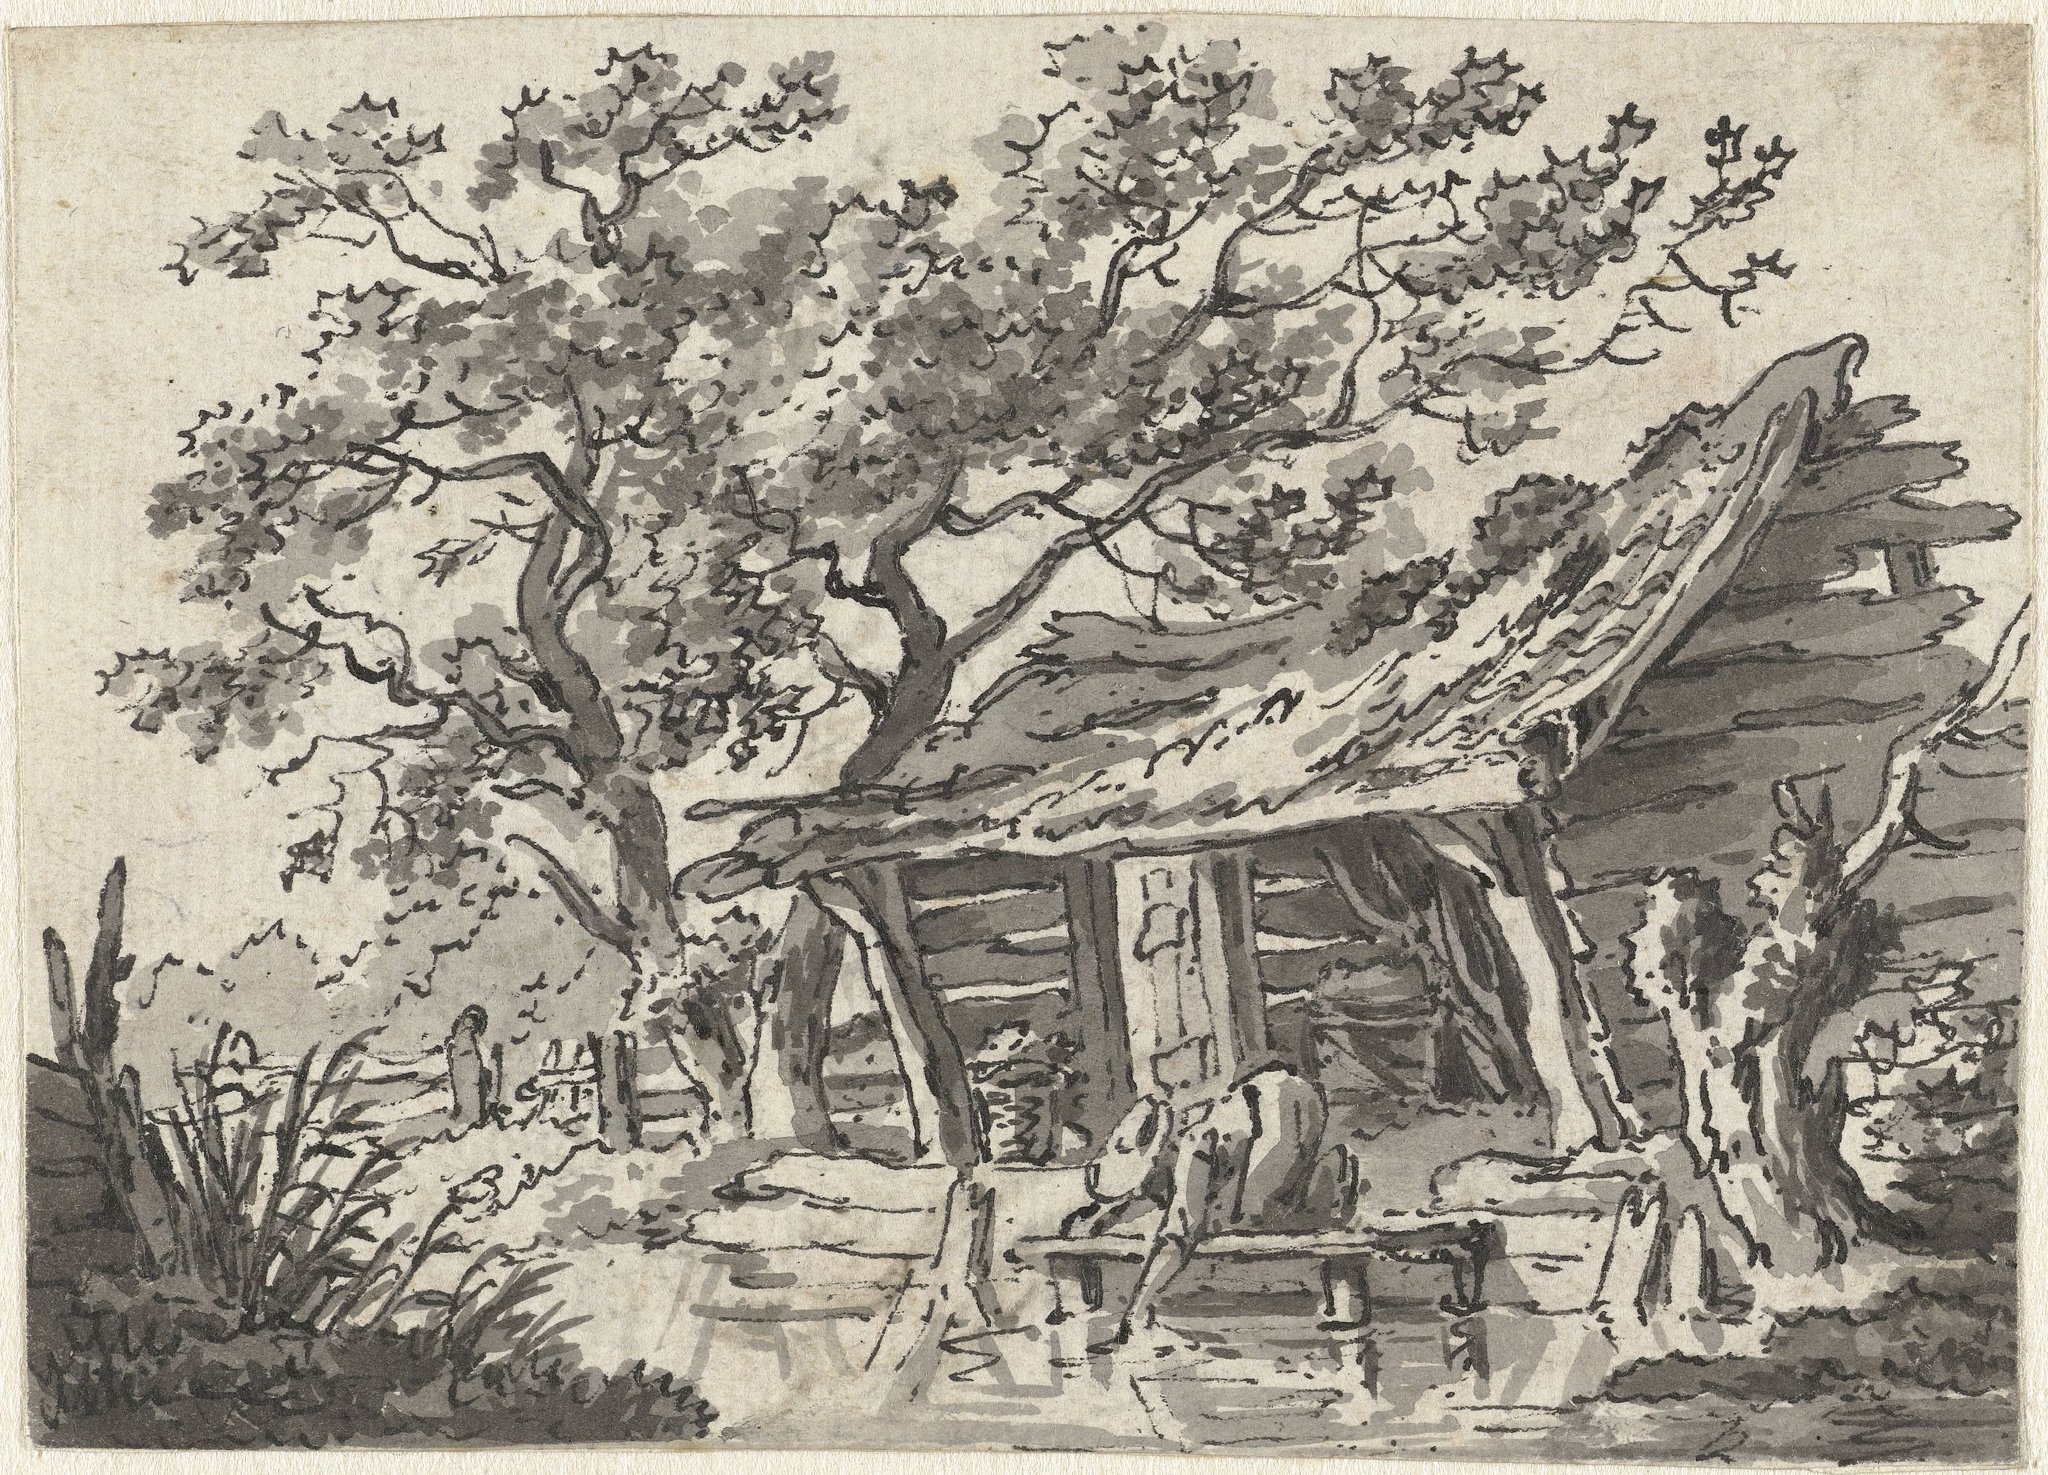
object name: drawing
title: Schuurtje aan het water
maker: françois joseph pfeiffer (ii)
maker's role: draughtsman, print maker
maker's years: 1778-1835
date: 1788-1835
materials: ink, paper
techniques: brush, pen